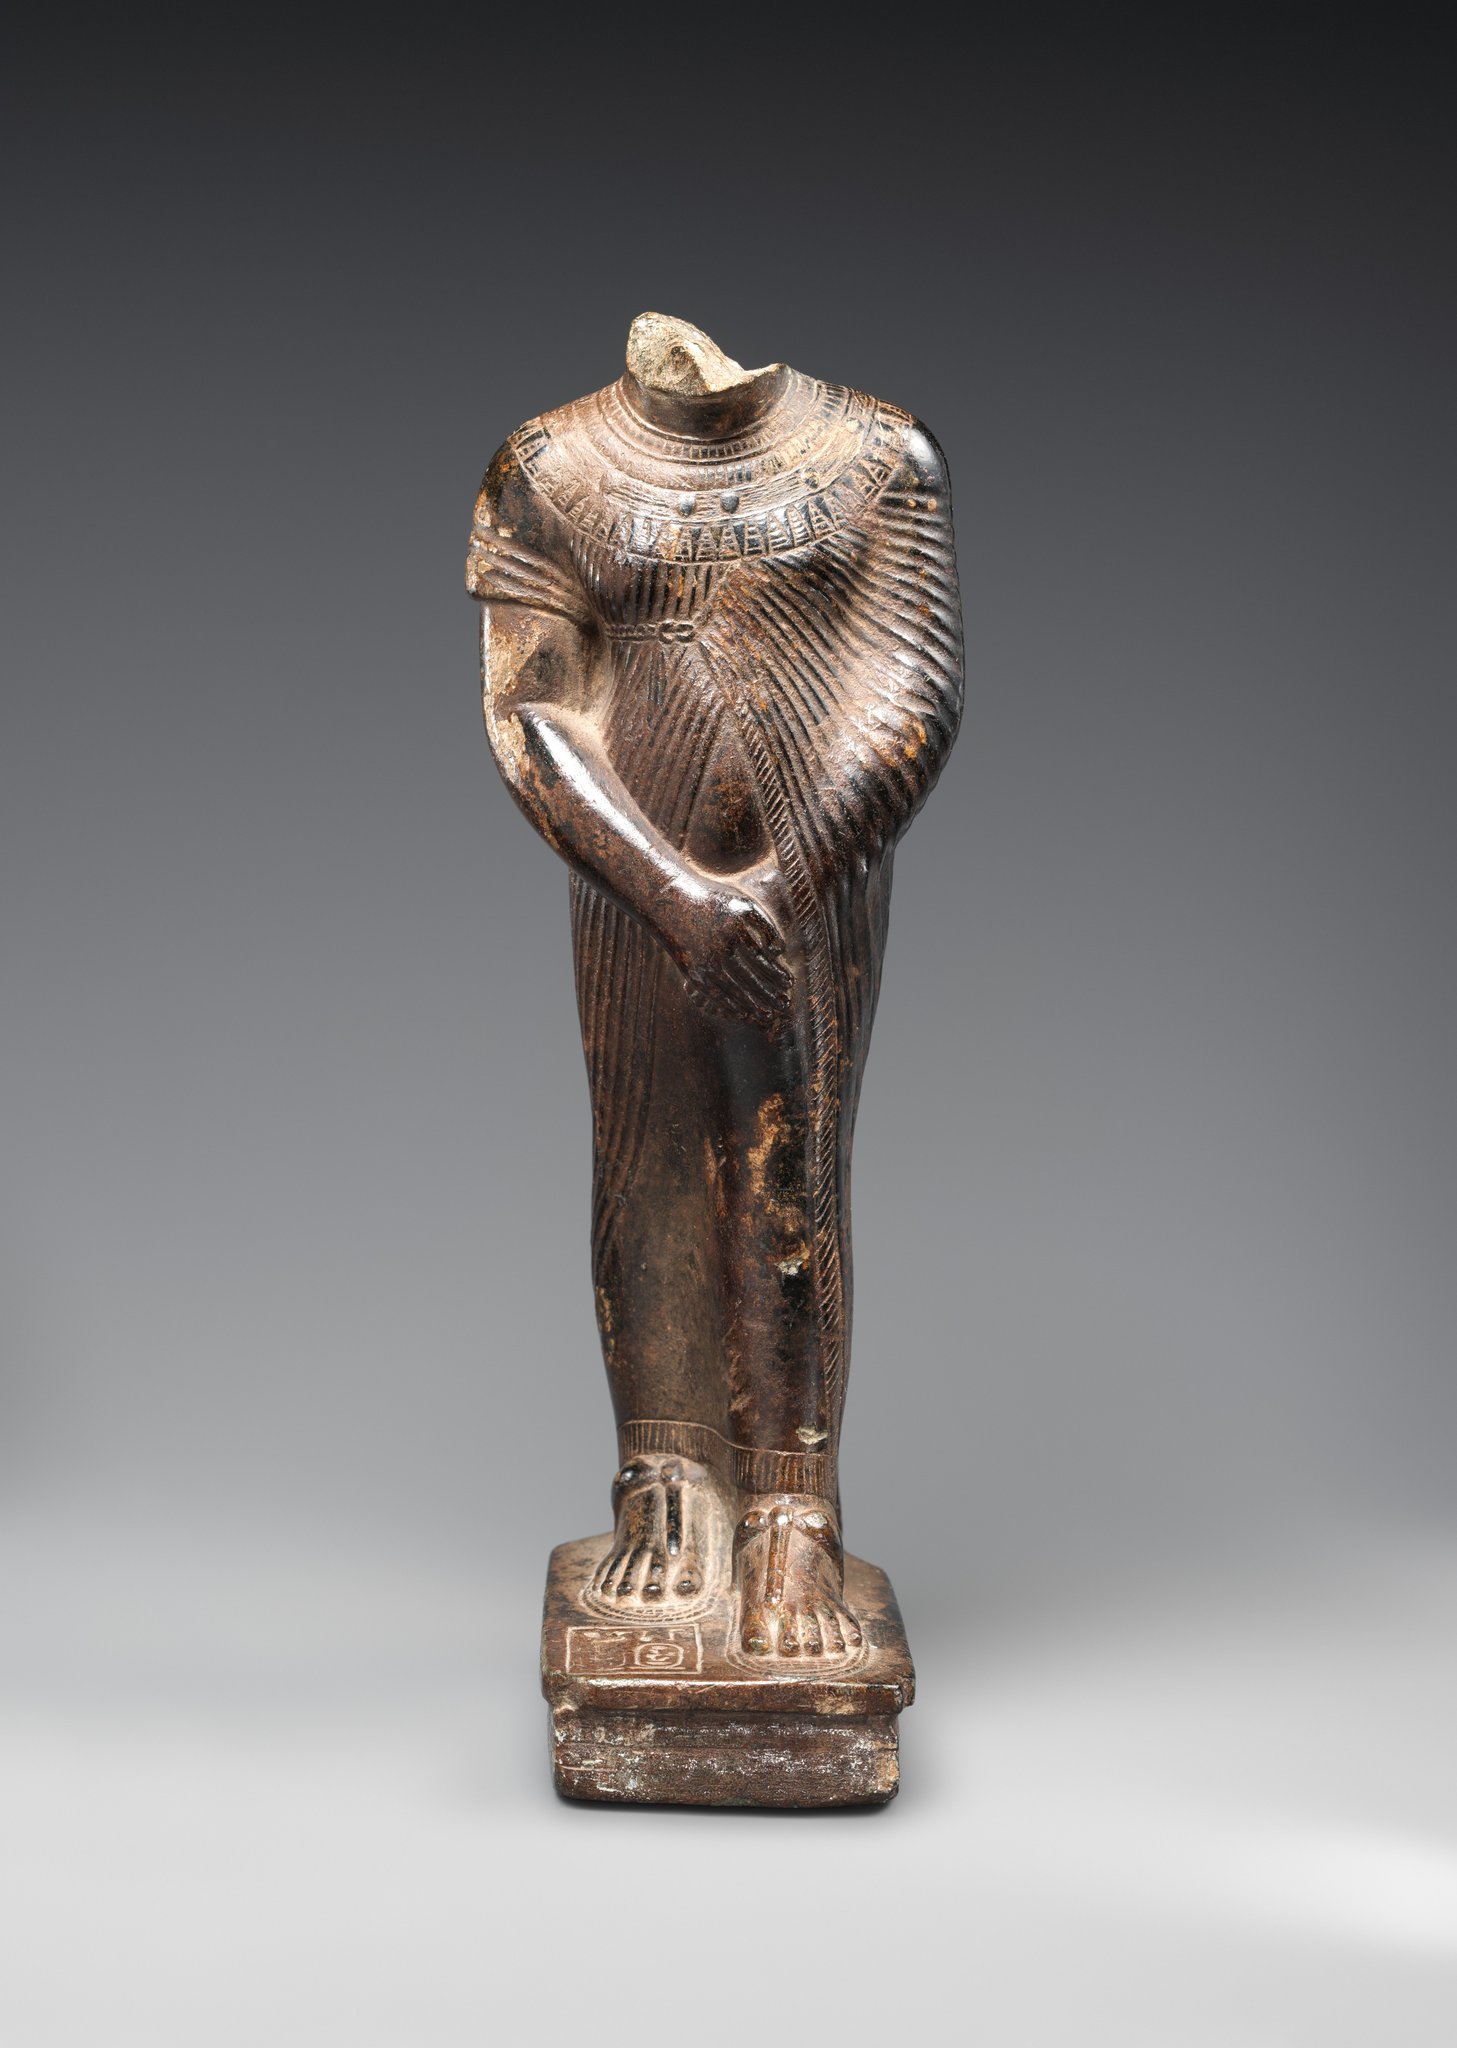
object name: statuette, standing king, amenhotep iii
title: Standing figure of Amenhotep III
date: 1390-1352 BCE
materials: mineral, stone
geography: egypt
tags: men